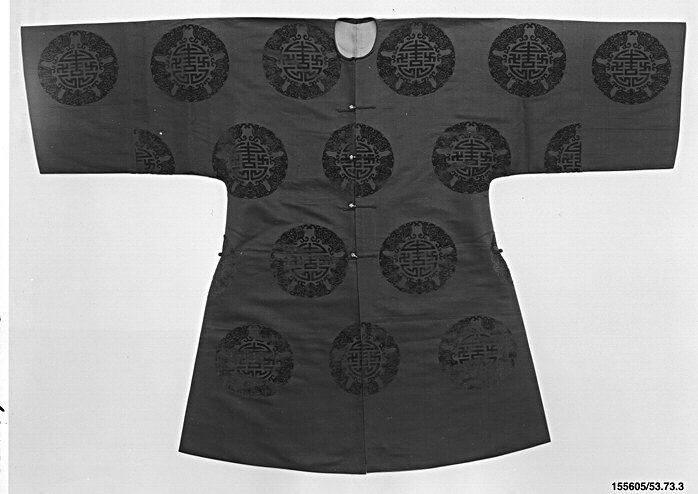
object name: woman's birthday coat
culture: chinese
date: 1867-1933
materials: textile